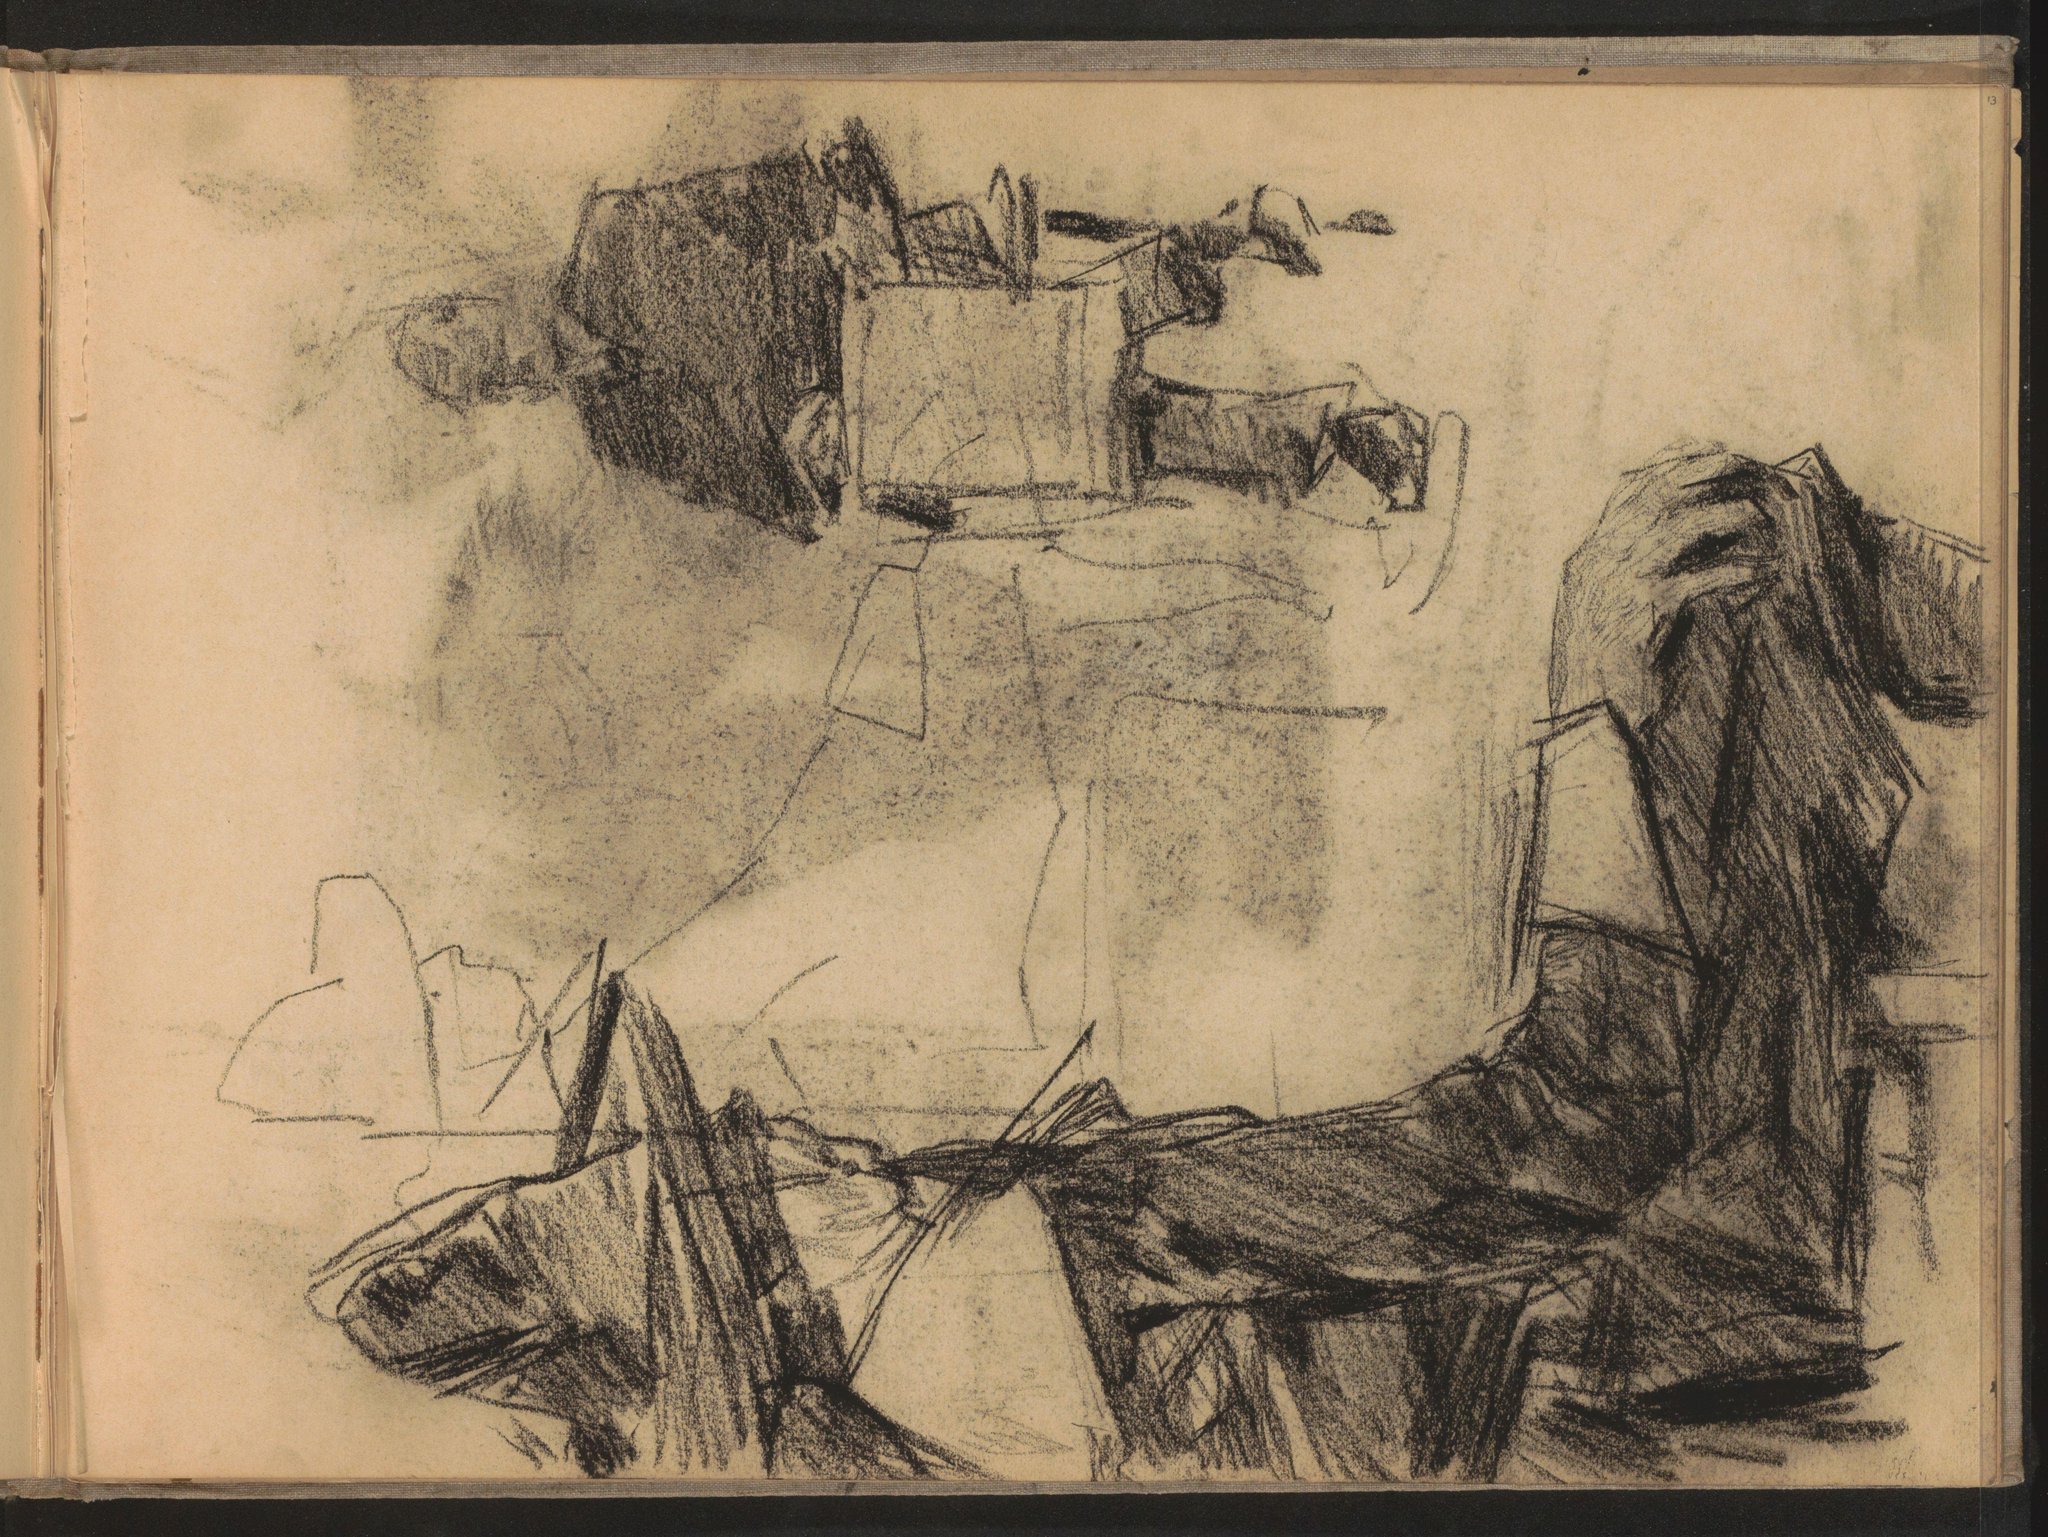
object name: sketchbook leaf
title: Zittende mannen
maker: marius bauer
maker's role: draughtsman, print maker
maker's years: 1867-1932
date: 1887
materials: chalk, paper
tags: sitting figure, adult man, head-gear: hat (+ men's clothes), historical costume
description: Eén figuur draagt historisch, mogelijk zeventiende-eeuws, kostuum. Pagina 13 uit een schetsboek met 19 bladen.